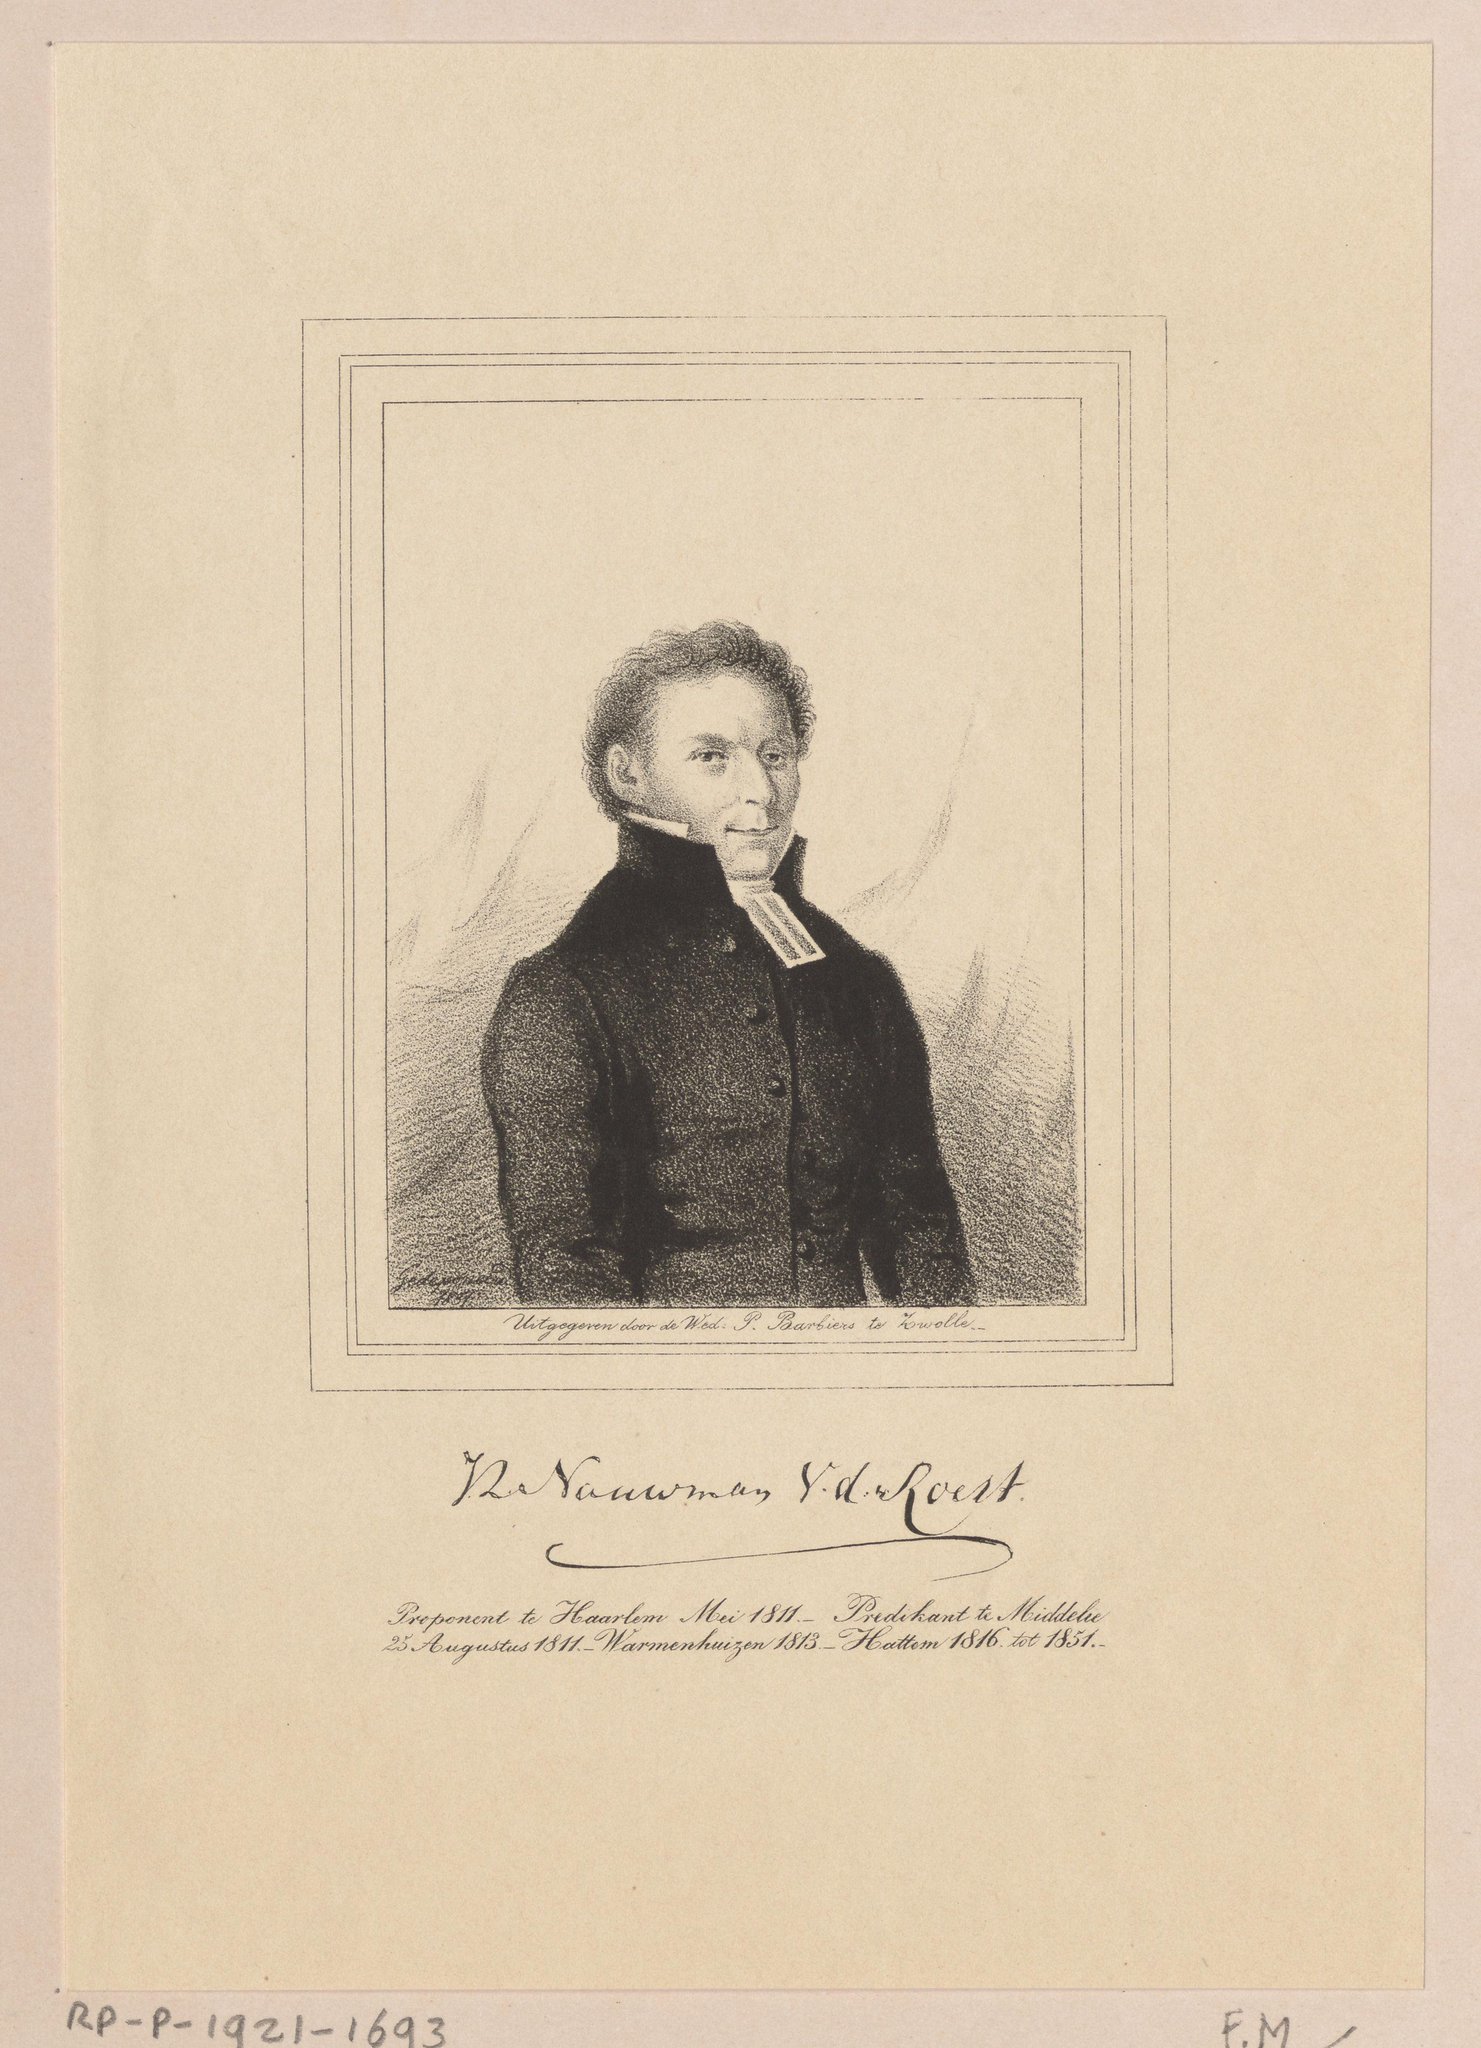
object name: print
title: Portret van Jan Zacharias Nauman van der Roest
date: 1851-1862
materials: paper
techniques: lithograph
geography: zwolle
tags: organizations, assemblies, etc. in protestant churches, historical persons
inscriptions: collector's mark: Lugt 2233